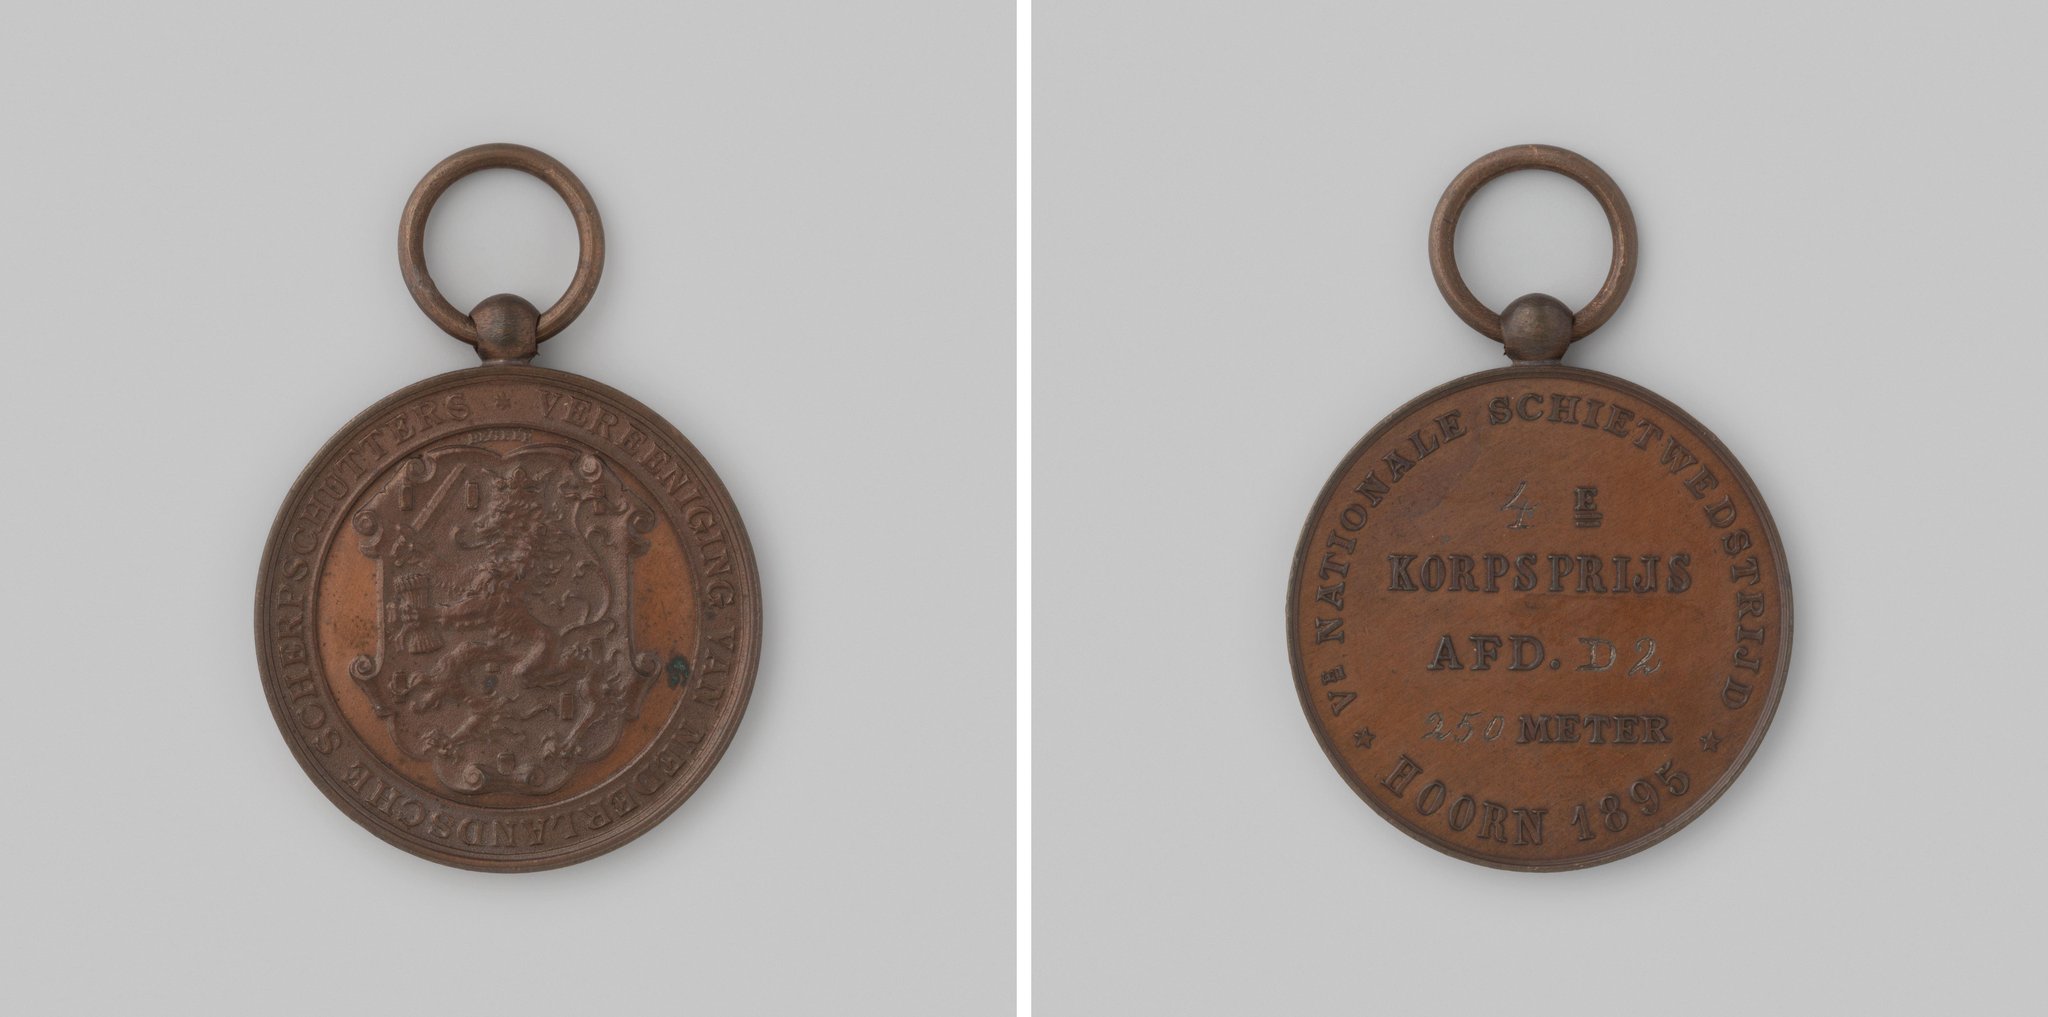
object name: draagpenning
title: Prijspenning van de Vereeniging Nederlandsche Scherpschutters 1895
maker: Anonymous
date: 1895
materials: metal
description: Penning met ring en oog van de Vereeniging Nederlandsche Scherpschutters, behaald door het regiment Schutterij van Amsterdam, 1895. Voorzijde: wapen van Nederland in renaissancestijl. Omschrift: VEREENIGING VAN NEDERLANDSCHE SCHERPSCHUTTERS. Keerzijde onbekend